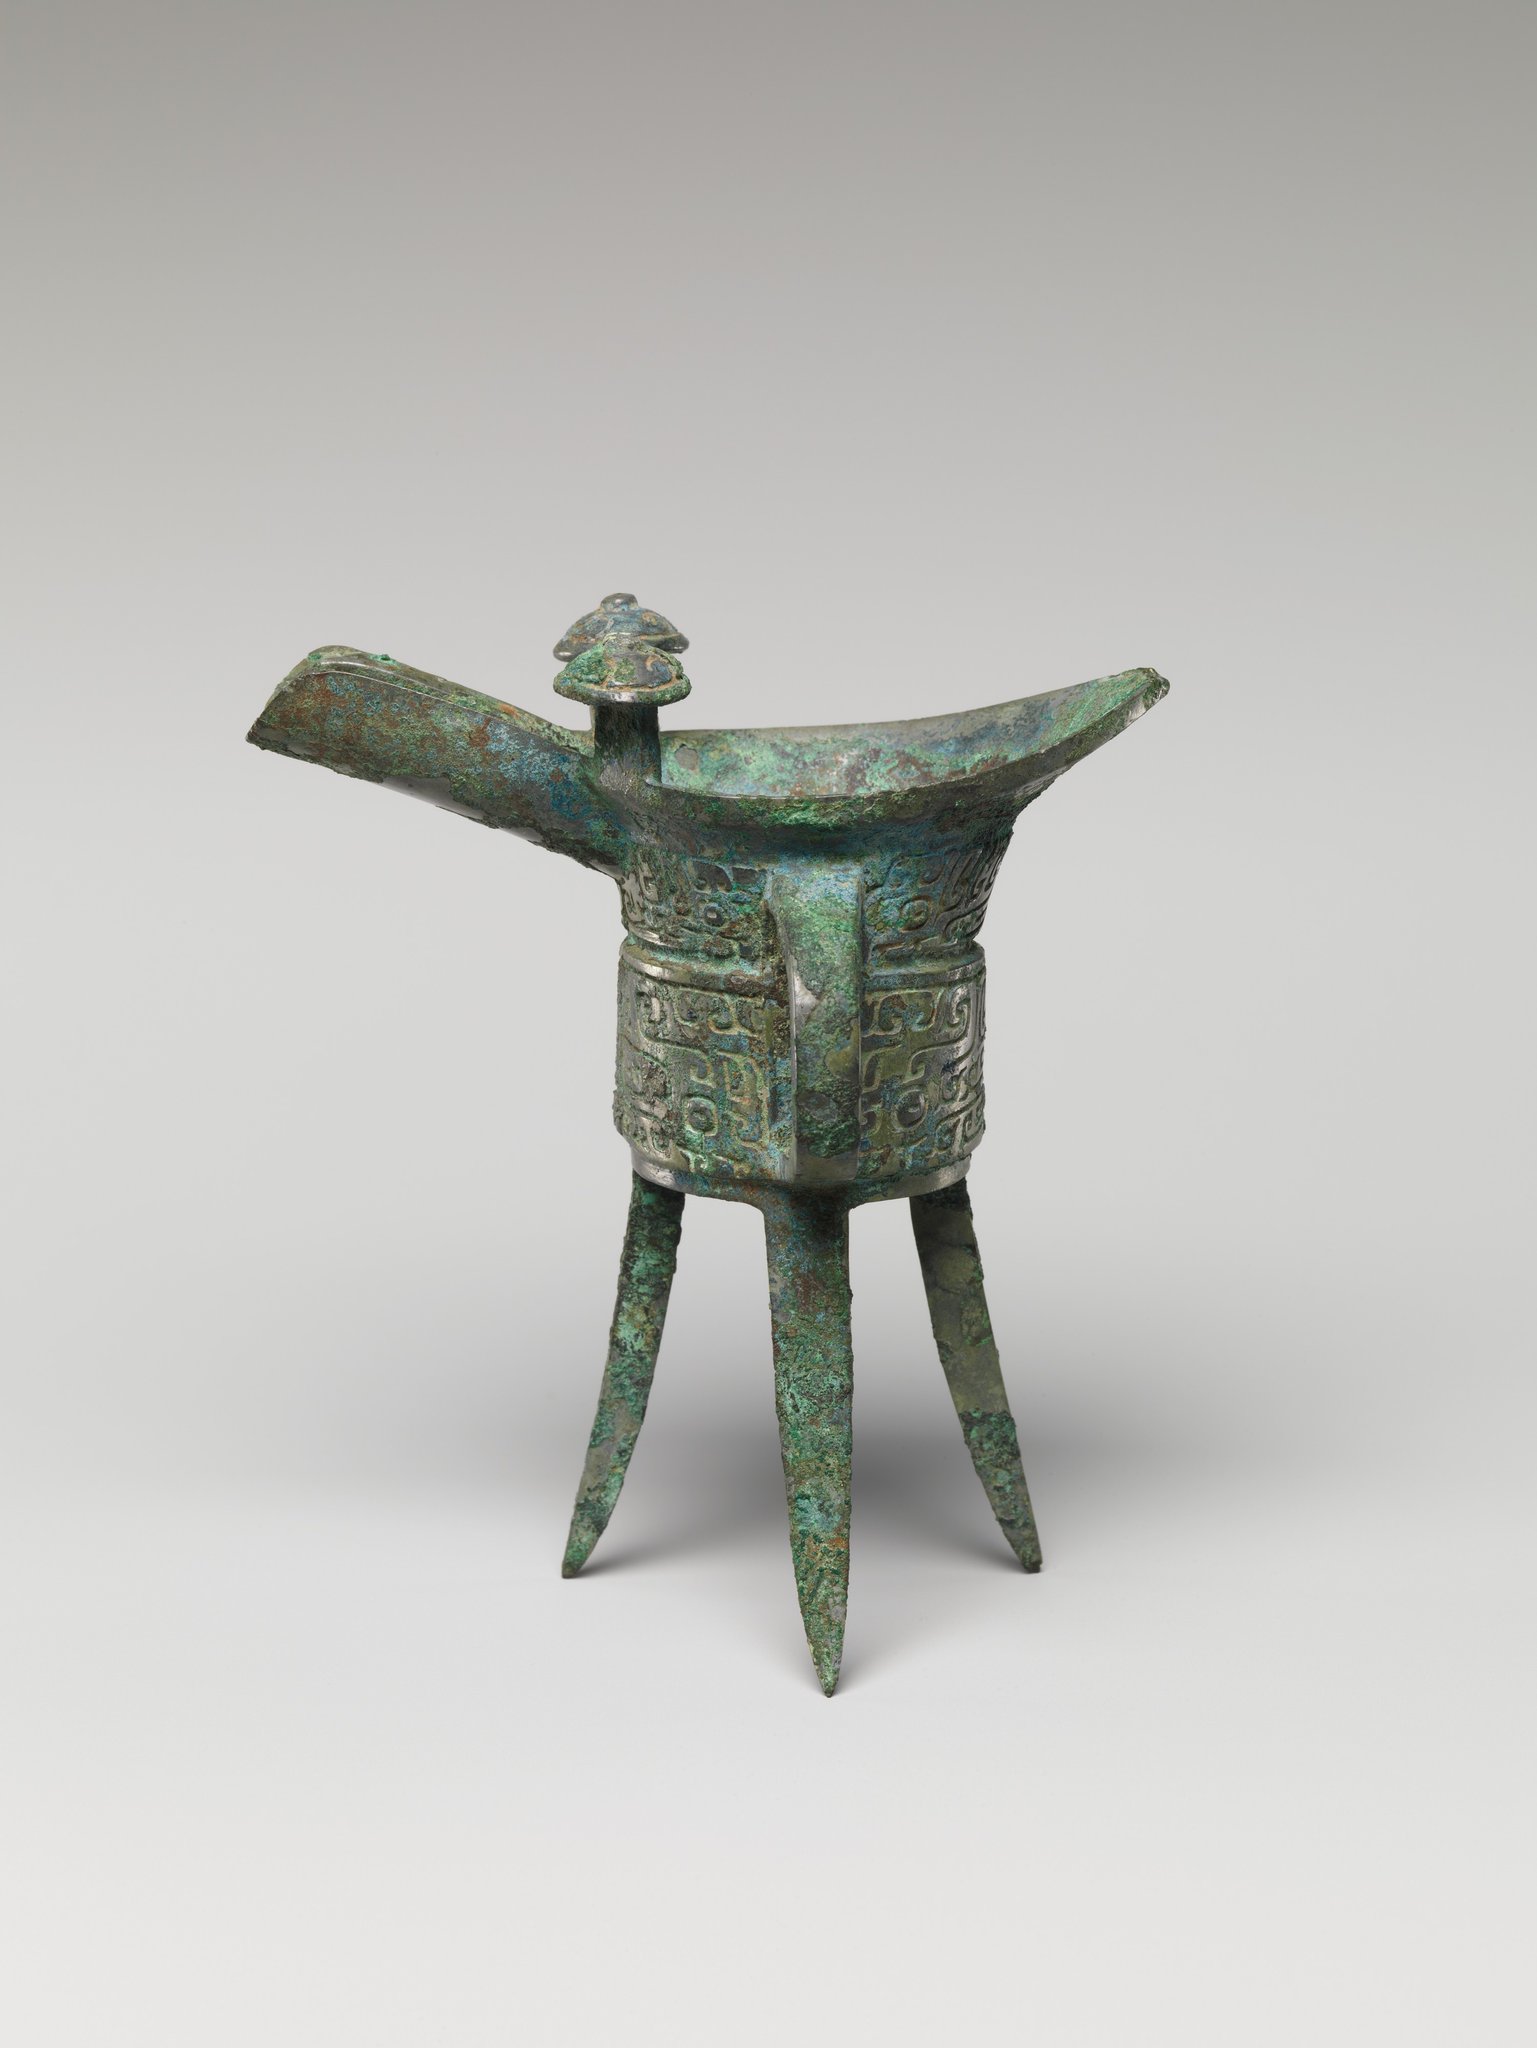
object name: wine warmer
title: Miniature wine warmer (Jue)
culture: chinese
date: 1334-1301 BCE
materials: bronze